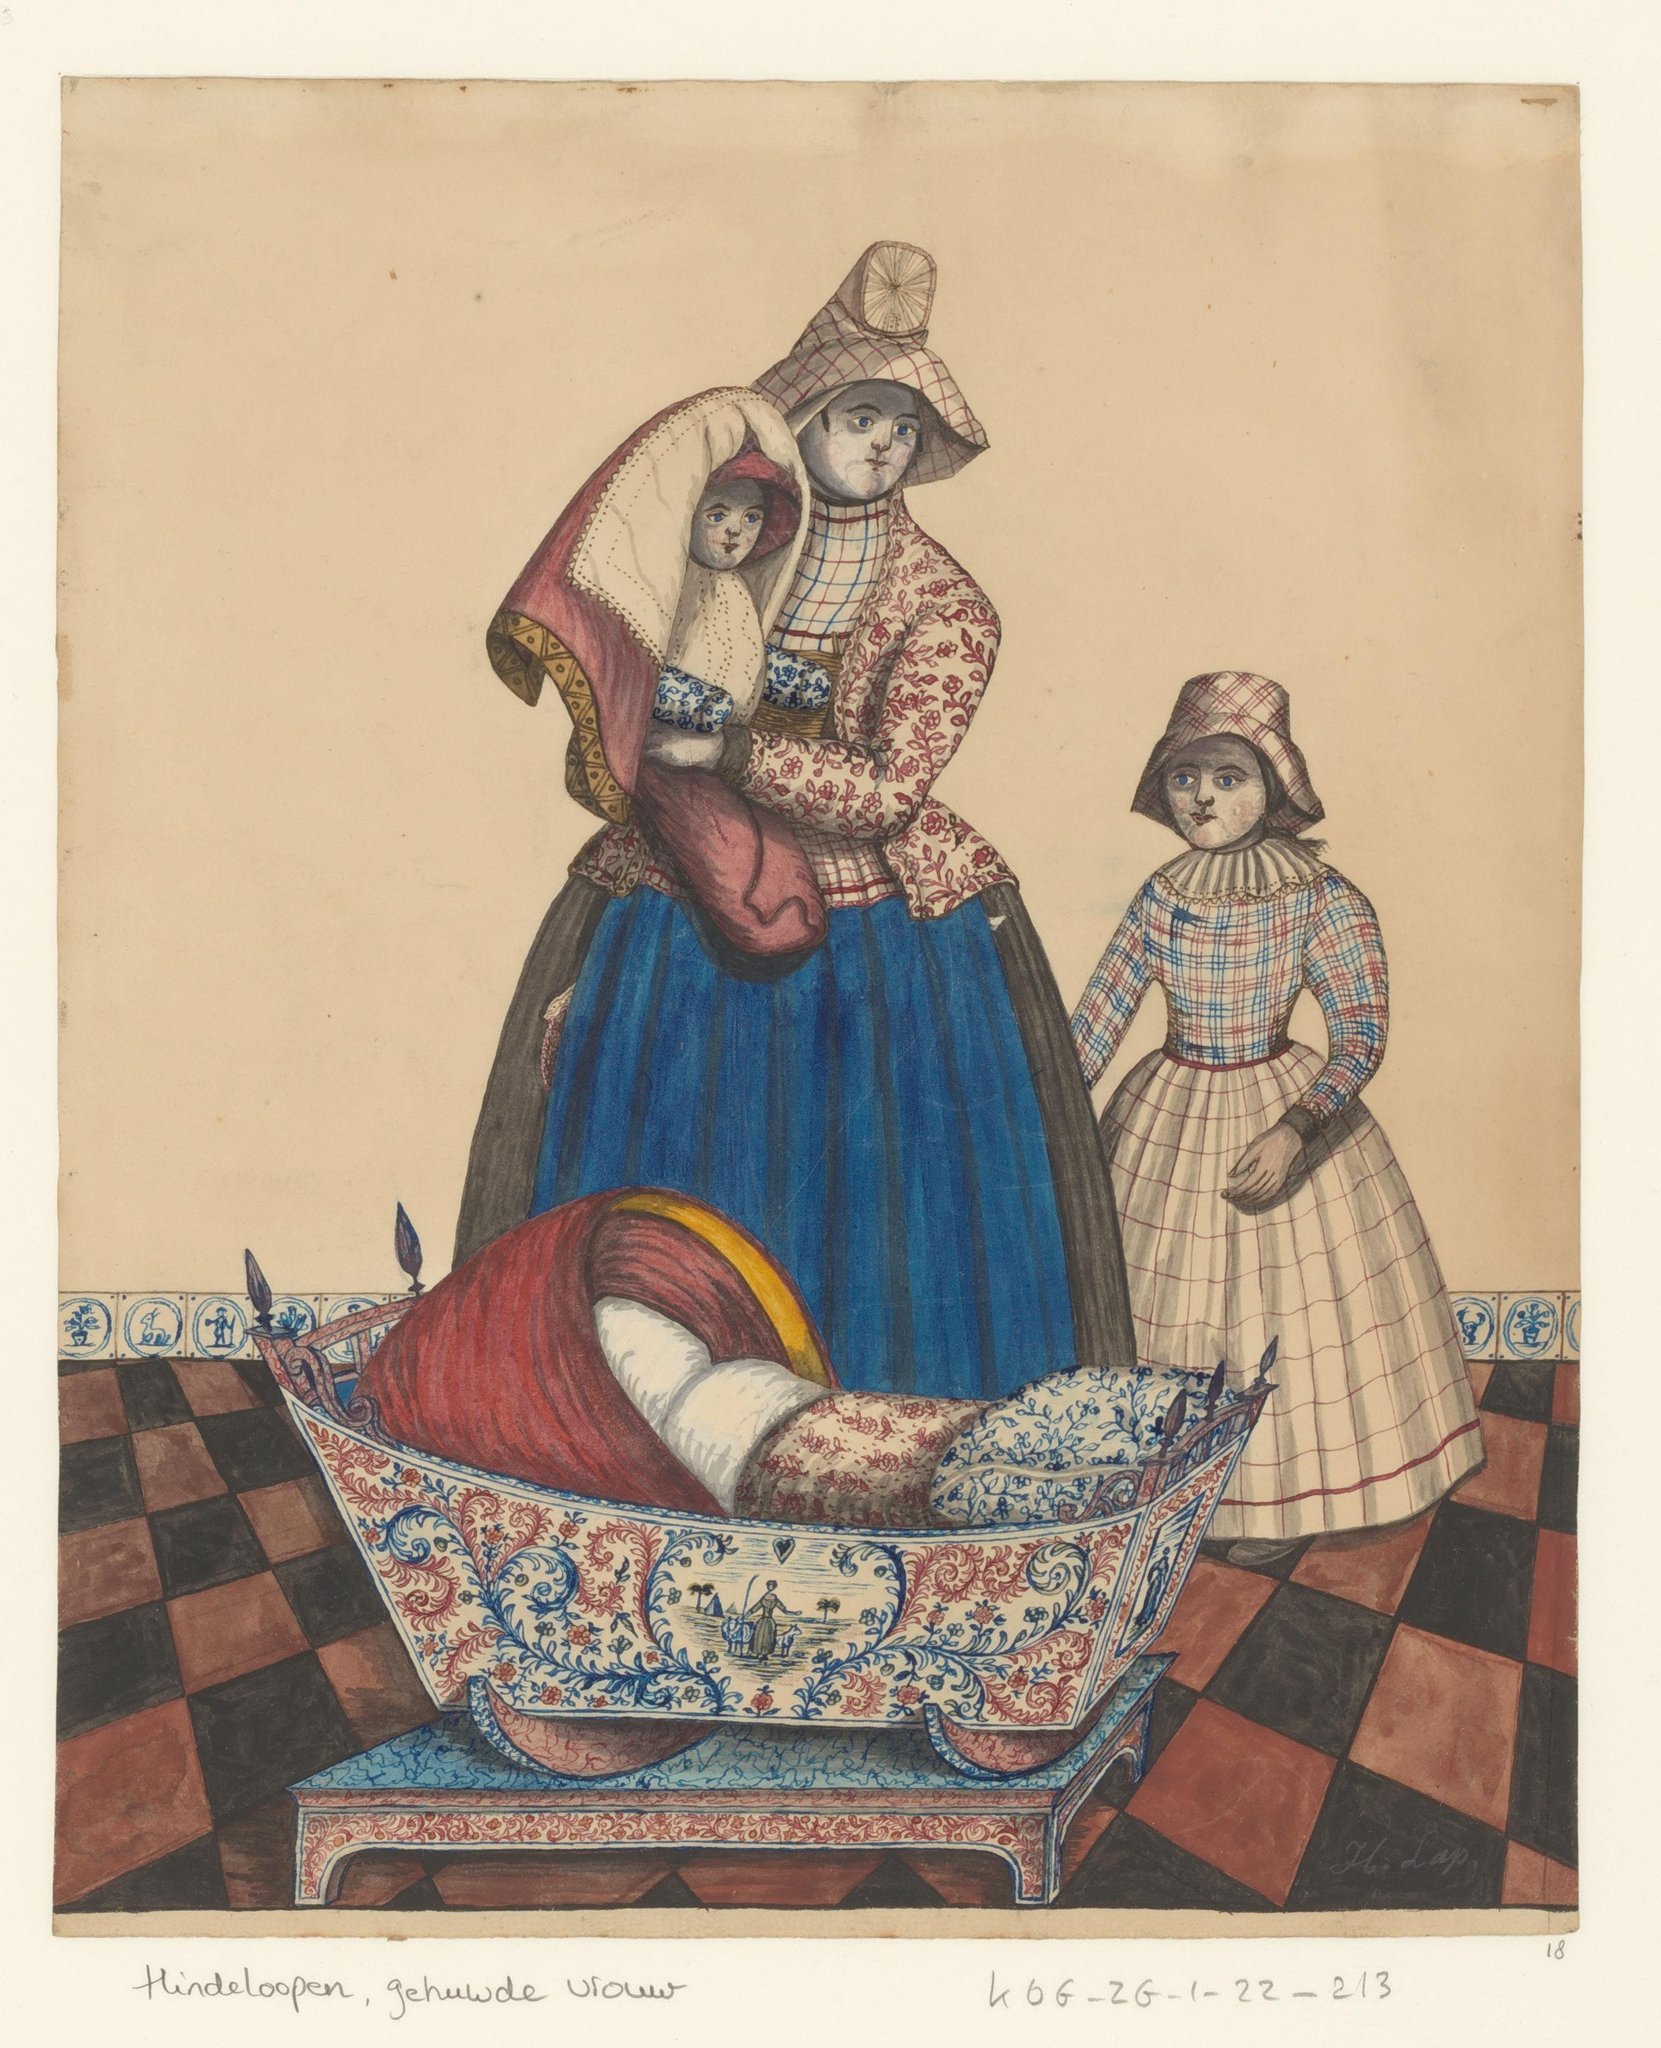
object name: drawing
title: Gehuwde vrouw met twee kinderen, van Hindeloopen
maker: hendrik lap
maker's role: draughtsman, painter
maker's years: 1824-1874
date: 1834-1874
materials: paper, watercolor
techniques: brush, pen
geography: hindeloopen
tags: clothes, costume (+ children's clothes), clothes, costume (+ women's clothes), cradle, crib, folk costume, regional costume, mother and child(ren), woman and child(ren) (family group)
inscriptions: collector's mark: Lugt 1641, collector's mark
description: Gehuwde vrouw met twee kinderen, van Hindeloopen. De moeder met het kind in de armen, pop de vloer een beschilderde wieg. Onderwerpsrubrieken binnen de Atlas Zeden en Gewoonten: De Kleeding, Volkskleederdracht, Friesland.